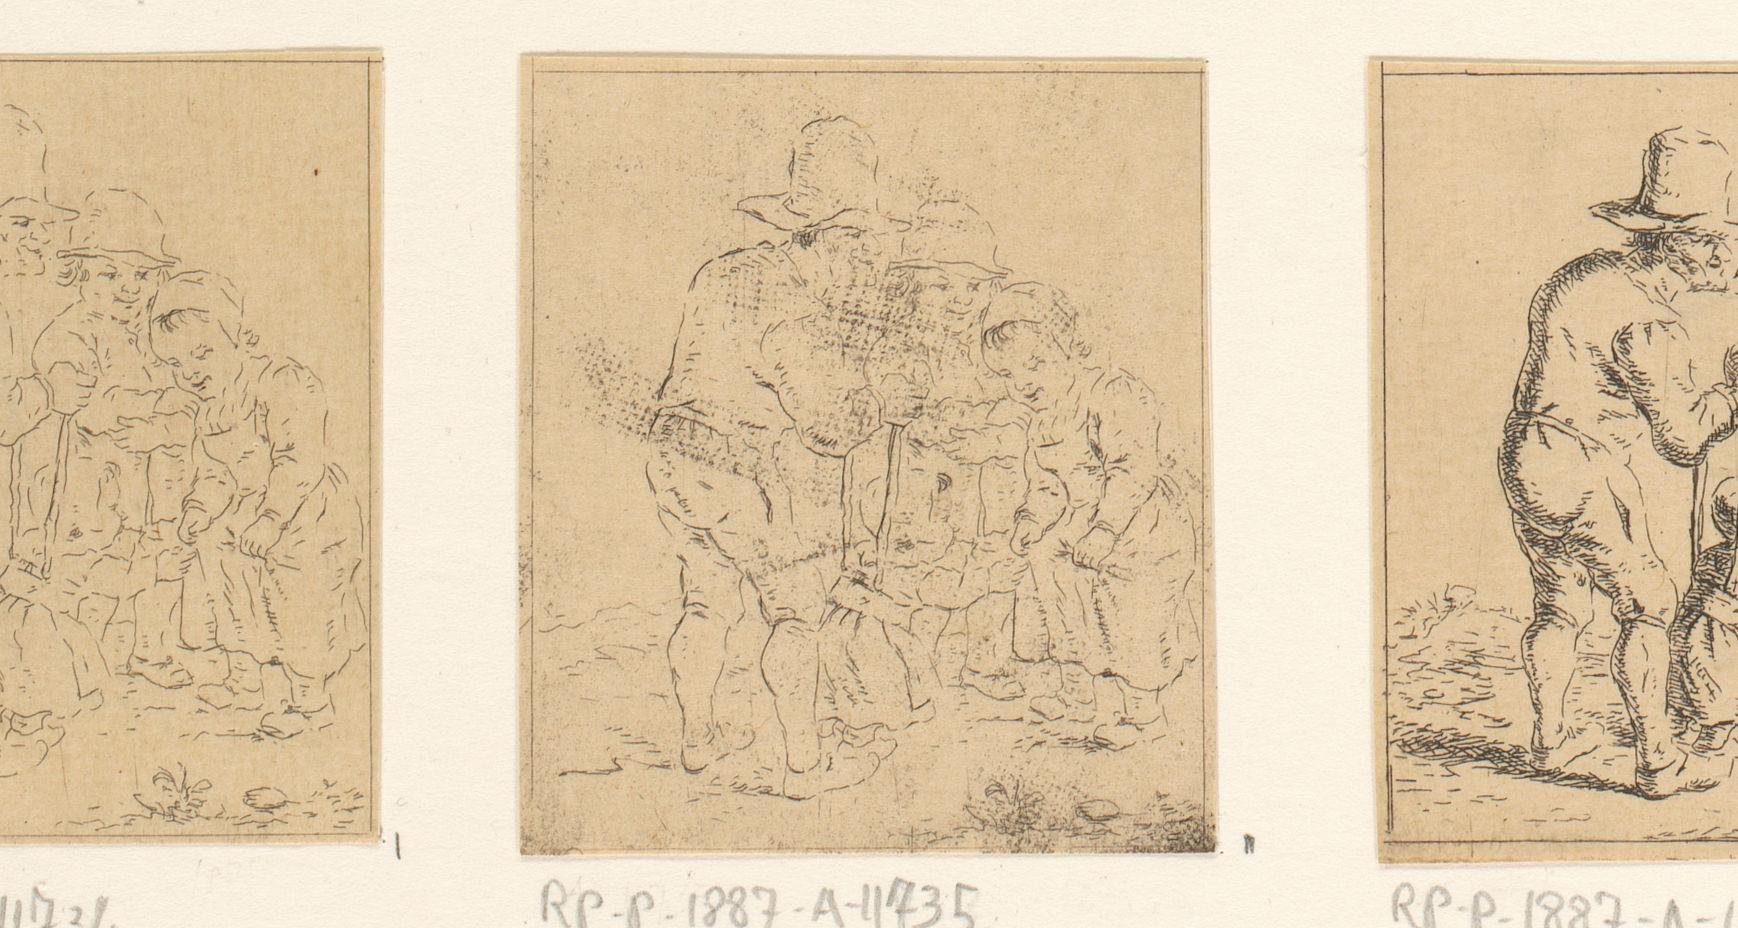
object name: print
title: Gezin leert kind lopen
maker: christina chalon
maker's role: draughtsman, print maker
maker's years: 1748-1808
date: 1758-1808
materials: paper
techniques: etching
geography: leiden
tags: child(ren) with one or both parents and one or more members of the preceding generation (family group), implements for learning to walk, go-cart, learning to walk, the first steps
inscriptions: collector's mark: Lugt 2228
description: Een oude man leert een peuter lopen door middel van een leiband en een tuigje. Moeder en vader lokken het kind naar hen toe.